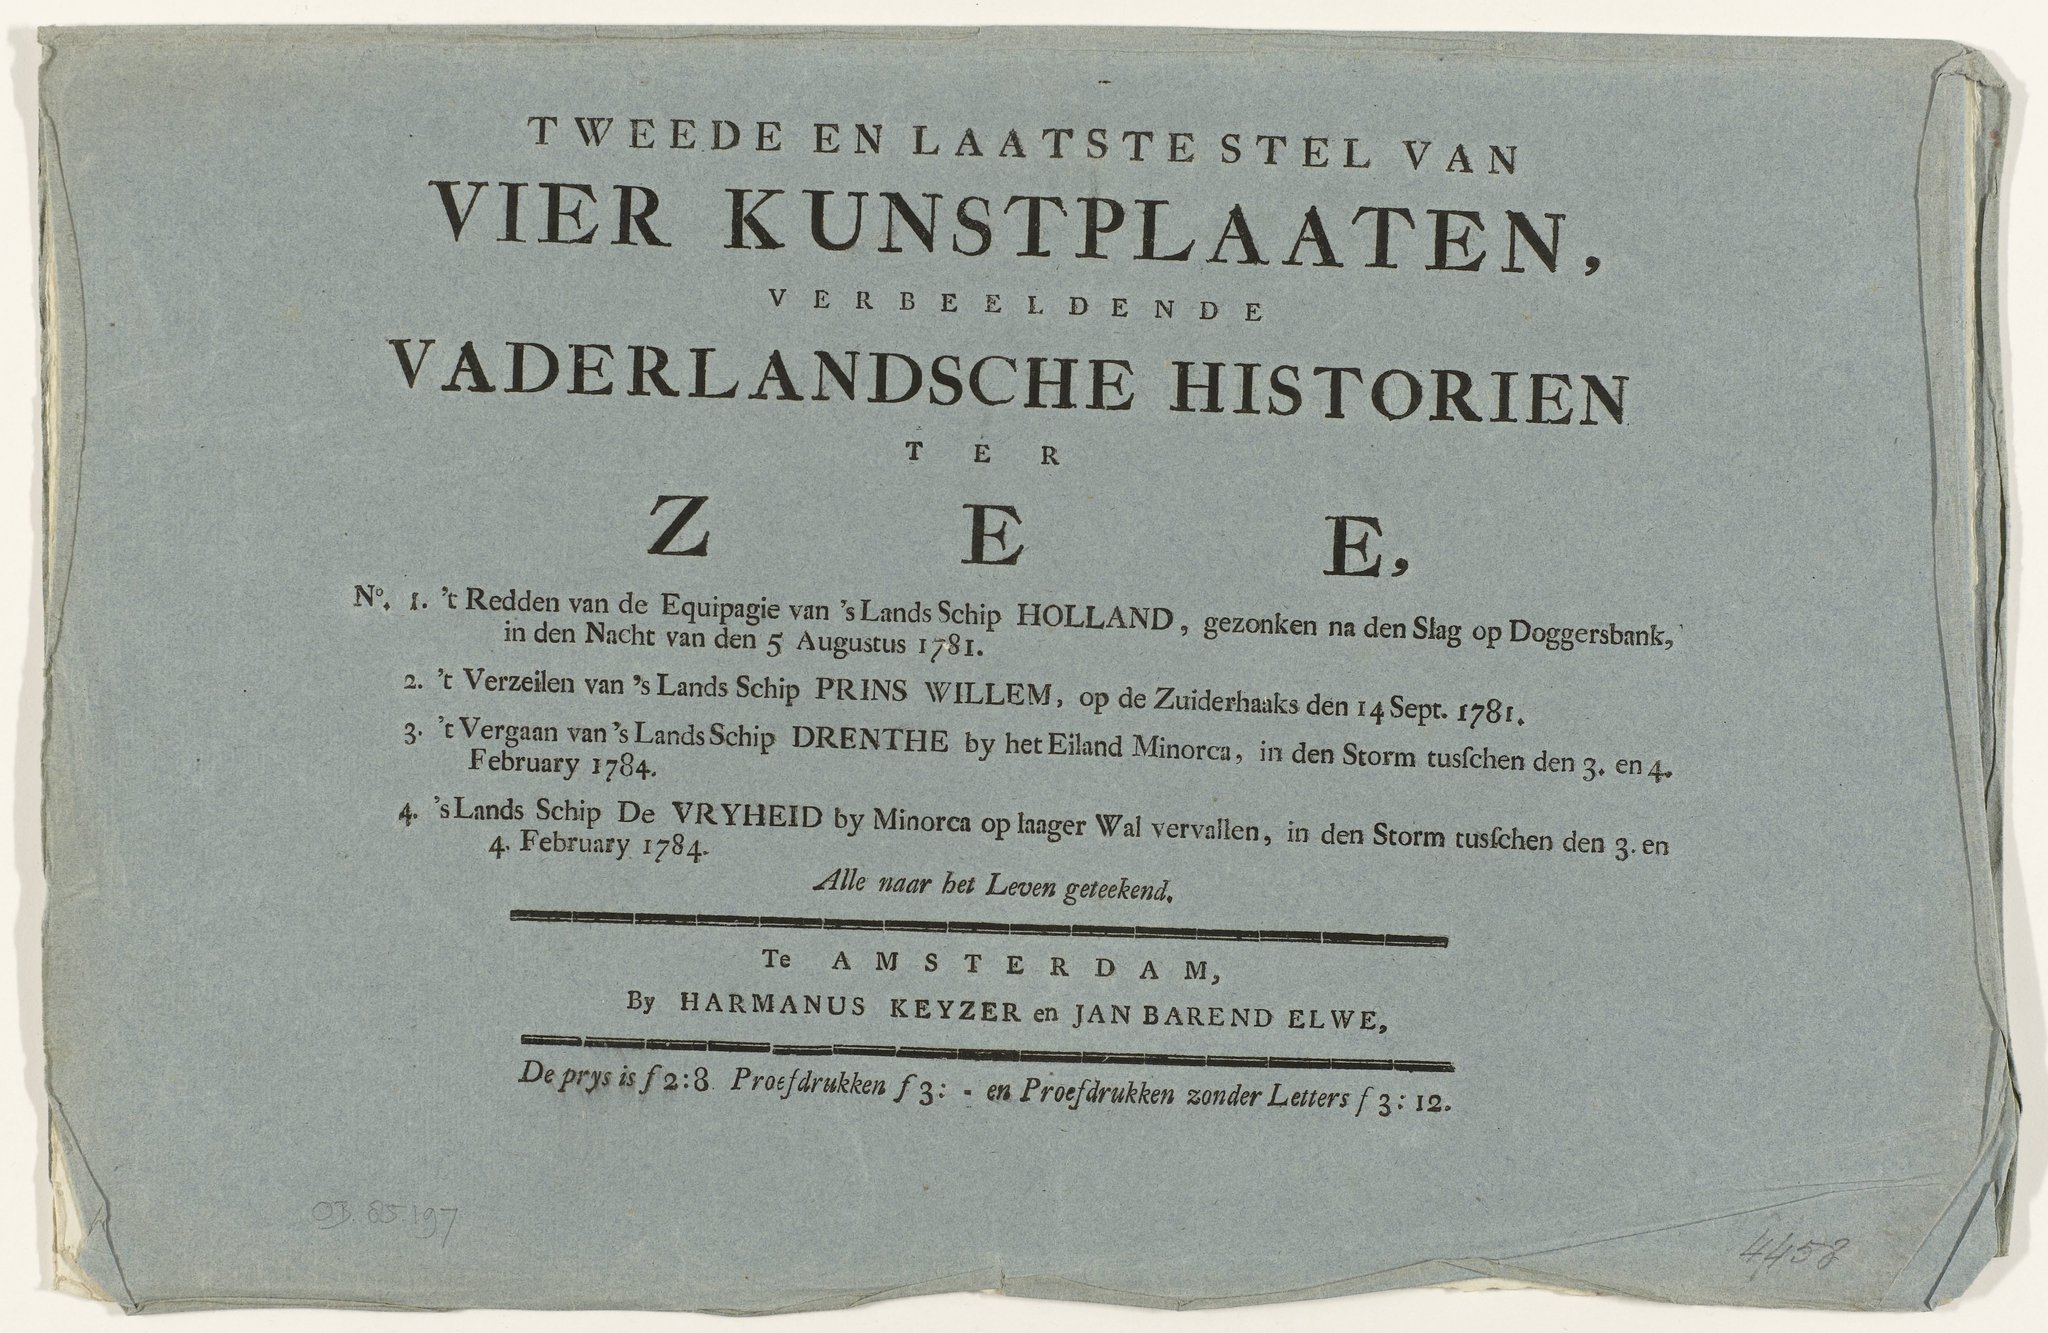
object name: print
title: Tweede en Laatste stel van Vier Kunstplaaten, verbeeldende Vaderlandsche Historien ter Zee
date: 1784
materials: paper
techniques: engraving, etching, letterpress printing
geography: northern netherlands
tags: fourth anglo-dutch war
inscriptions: collector's mark: Lugt 2228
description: Map met vier prenten van historische gebeurtenissen op zee in de jaren 1781-1784, tweede serie. Omslag van blauw papier met de serietitel, de onderwerpen van de vier voorstellingen, de namen van de uitgevers en de prijzen.